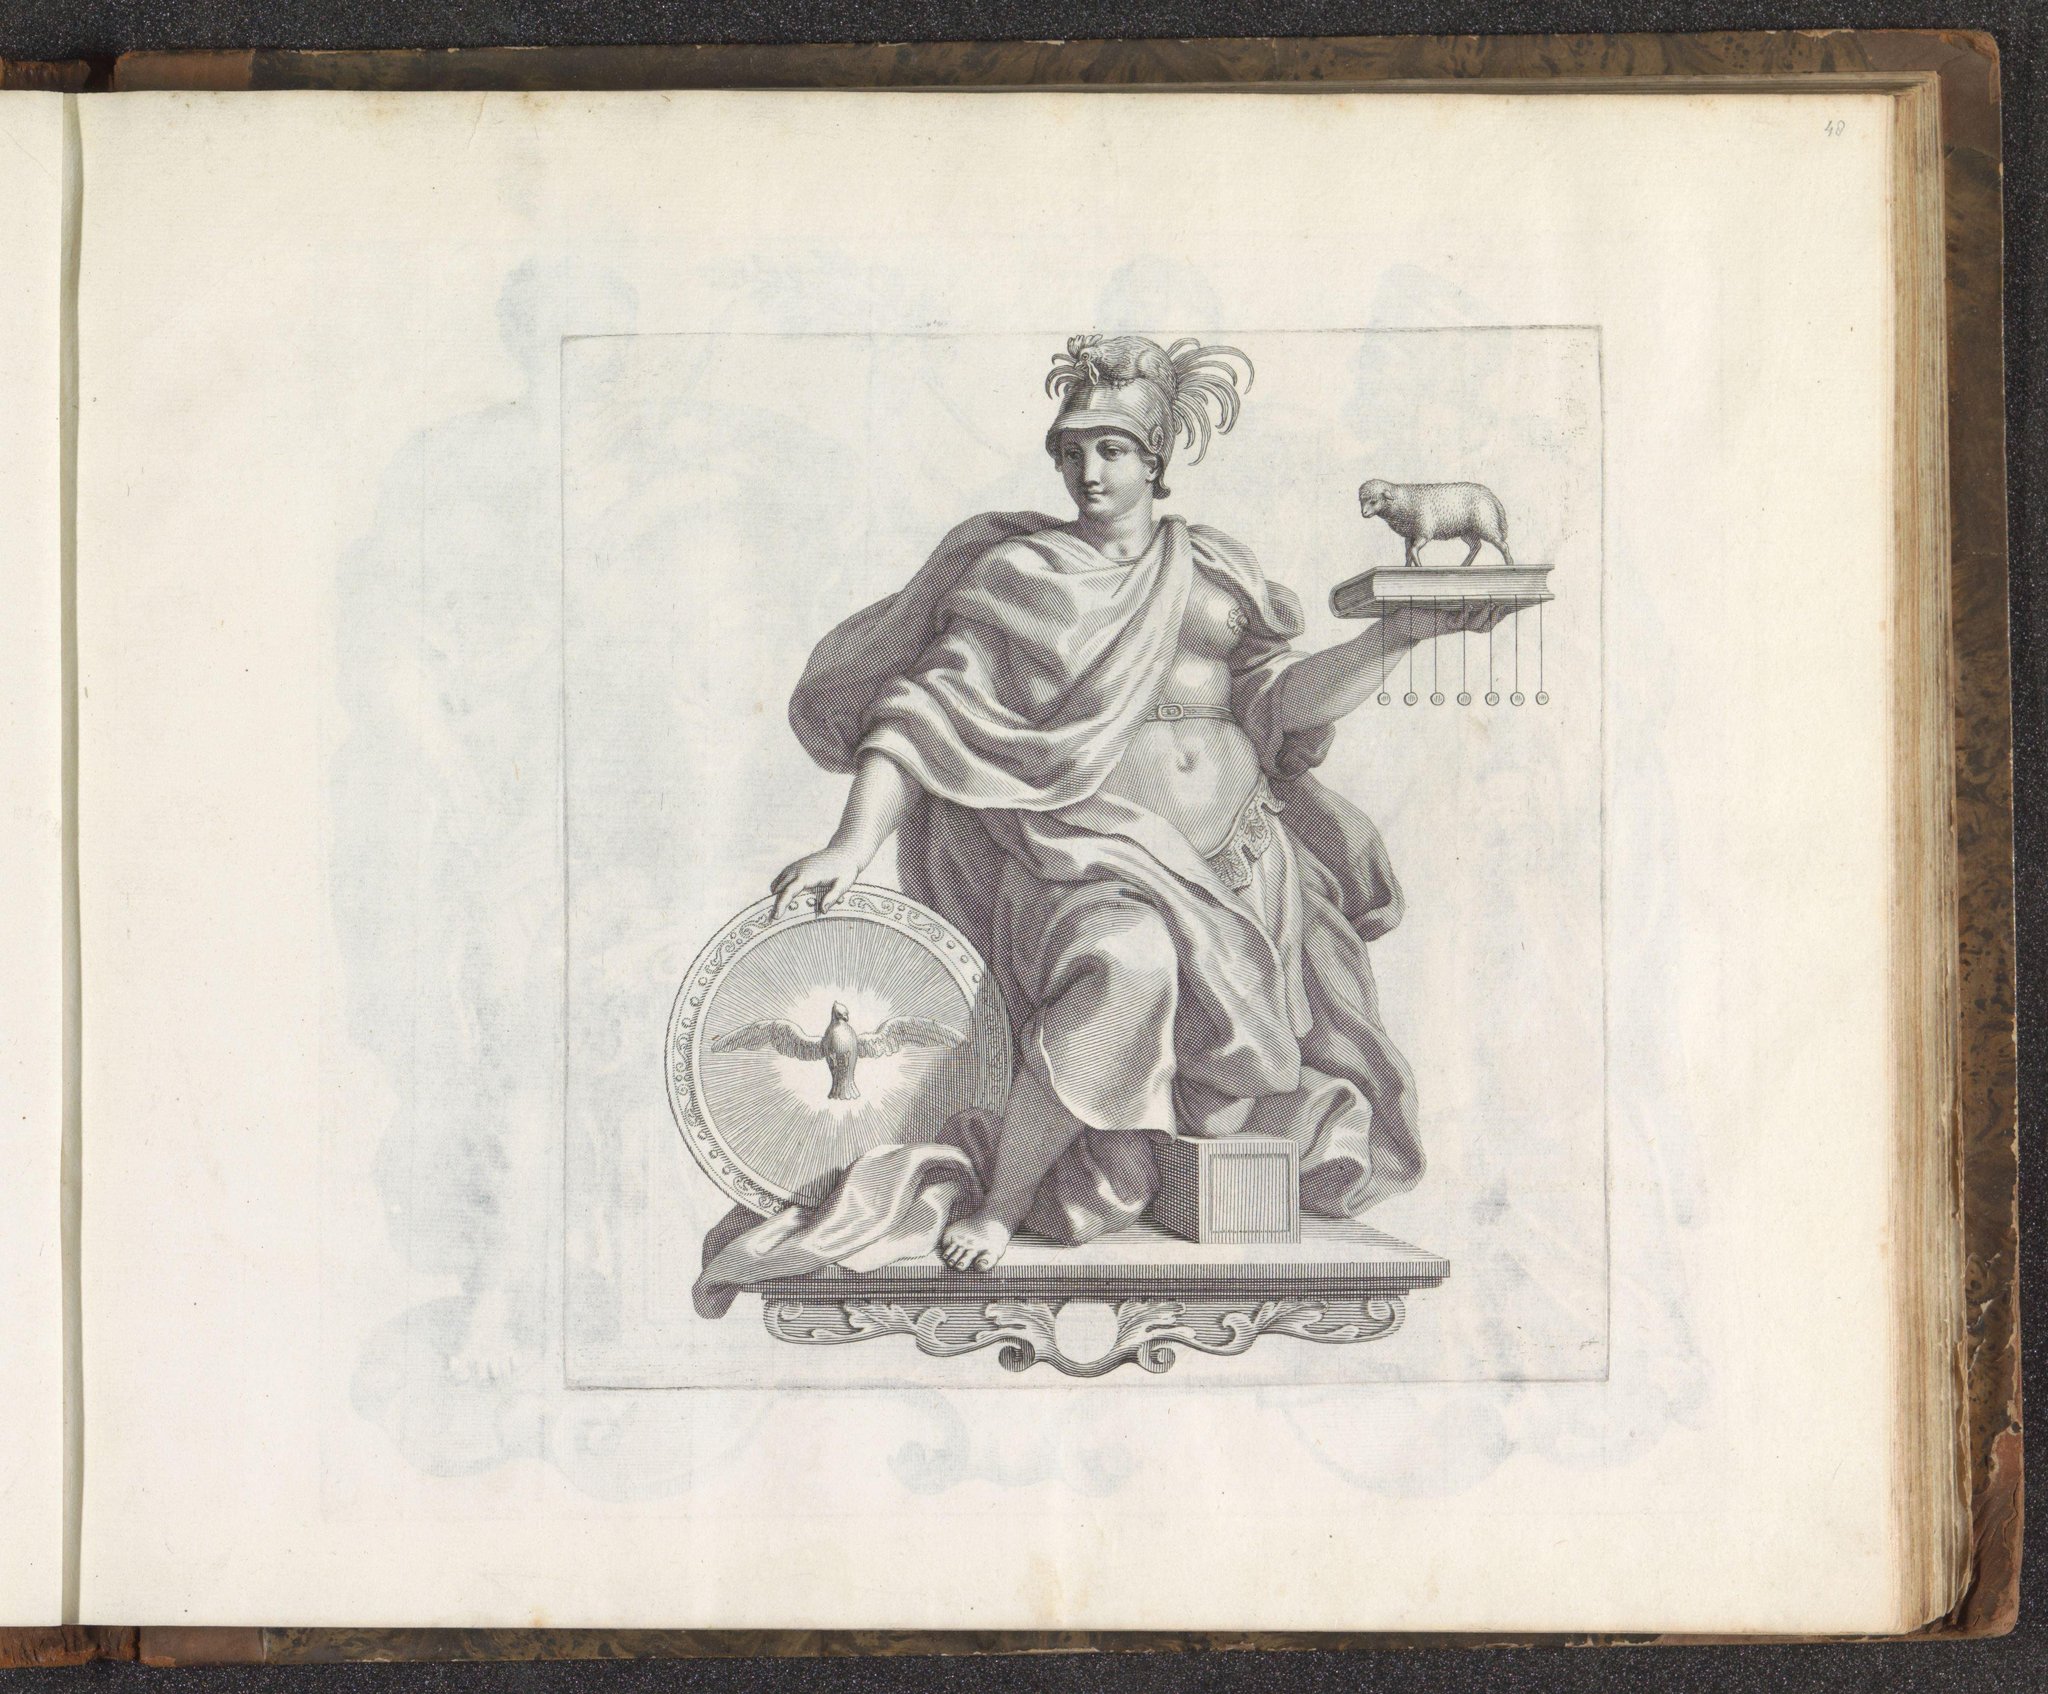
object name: album leaf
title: Personificatie van de Goddelijke Wijsheid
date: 1673-1743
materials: paper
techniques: engraving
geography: rome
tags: lamb, fowl (cock, hen, chicken, etc.), the book with the seven seals enthroned ~ revelation of john, 'sapientia', wisdom; 'sapienza divina' (ripa) ~ one of the seven gifts of the holy ghost, holy ghost represented as a dove (in flames)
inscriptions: collector's mark: Lugt 2228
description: Een console met de vrouwelijke personificatie van de Goddelijke Wijsheid. De vrouw knielt op een vierkanten steen. Ze draagt een borststuk en een helm met daarop een haan. In haar rechterhand een rond schild met de Heilige Geest in de vorm van een duif. In haar linkerhand heeft ze het Boek der Wijsheid, gesloten met zeven zegels en bovenop het Lam Gods. De prent maakt deel uit van een album.